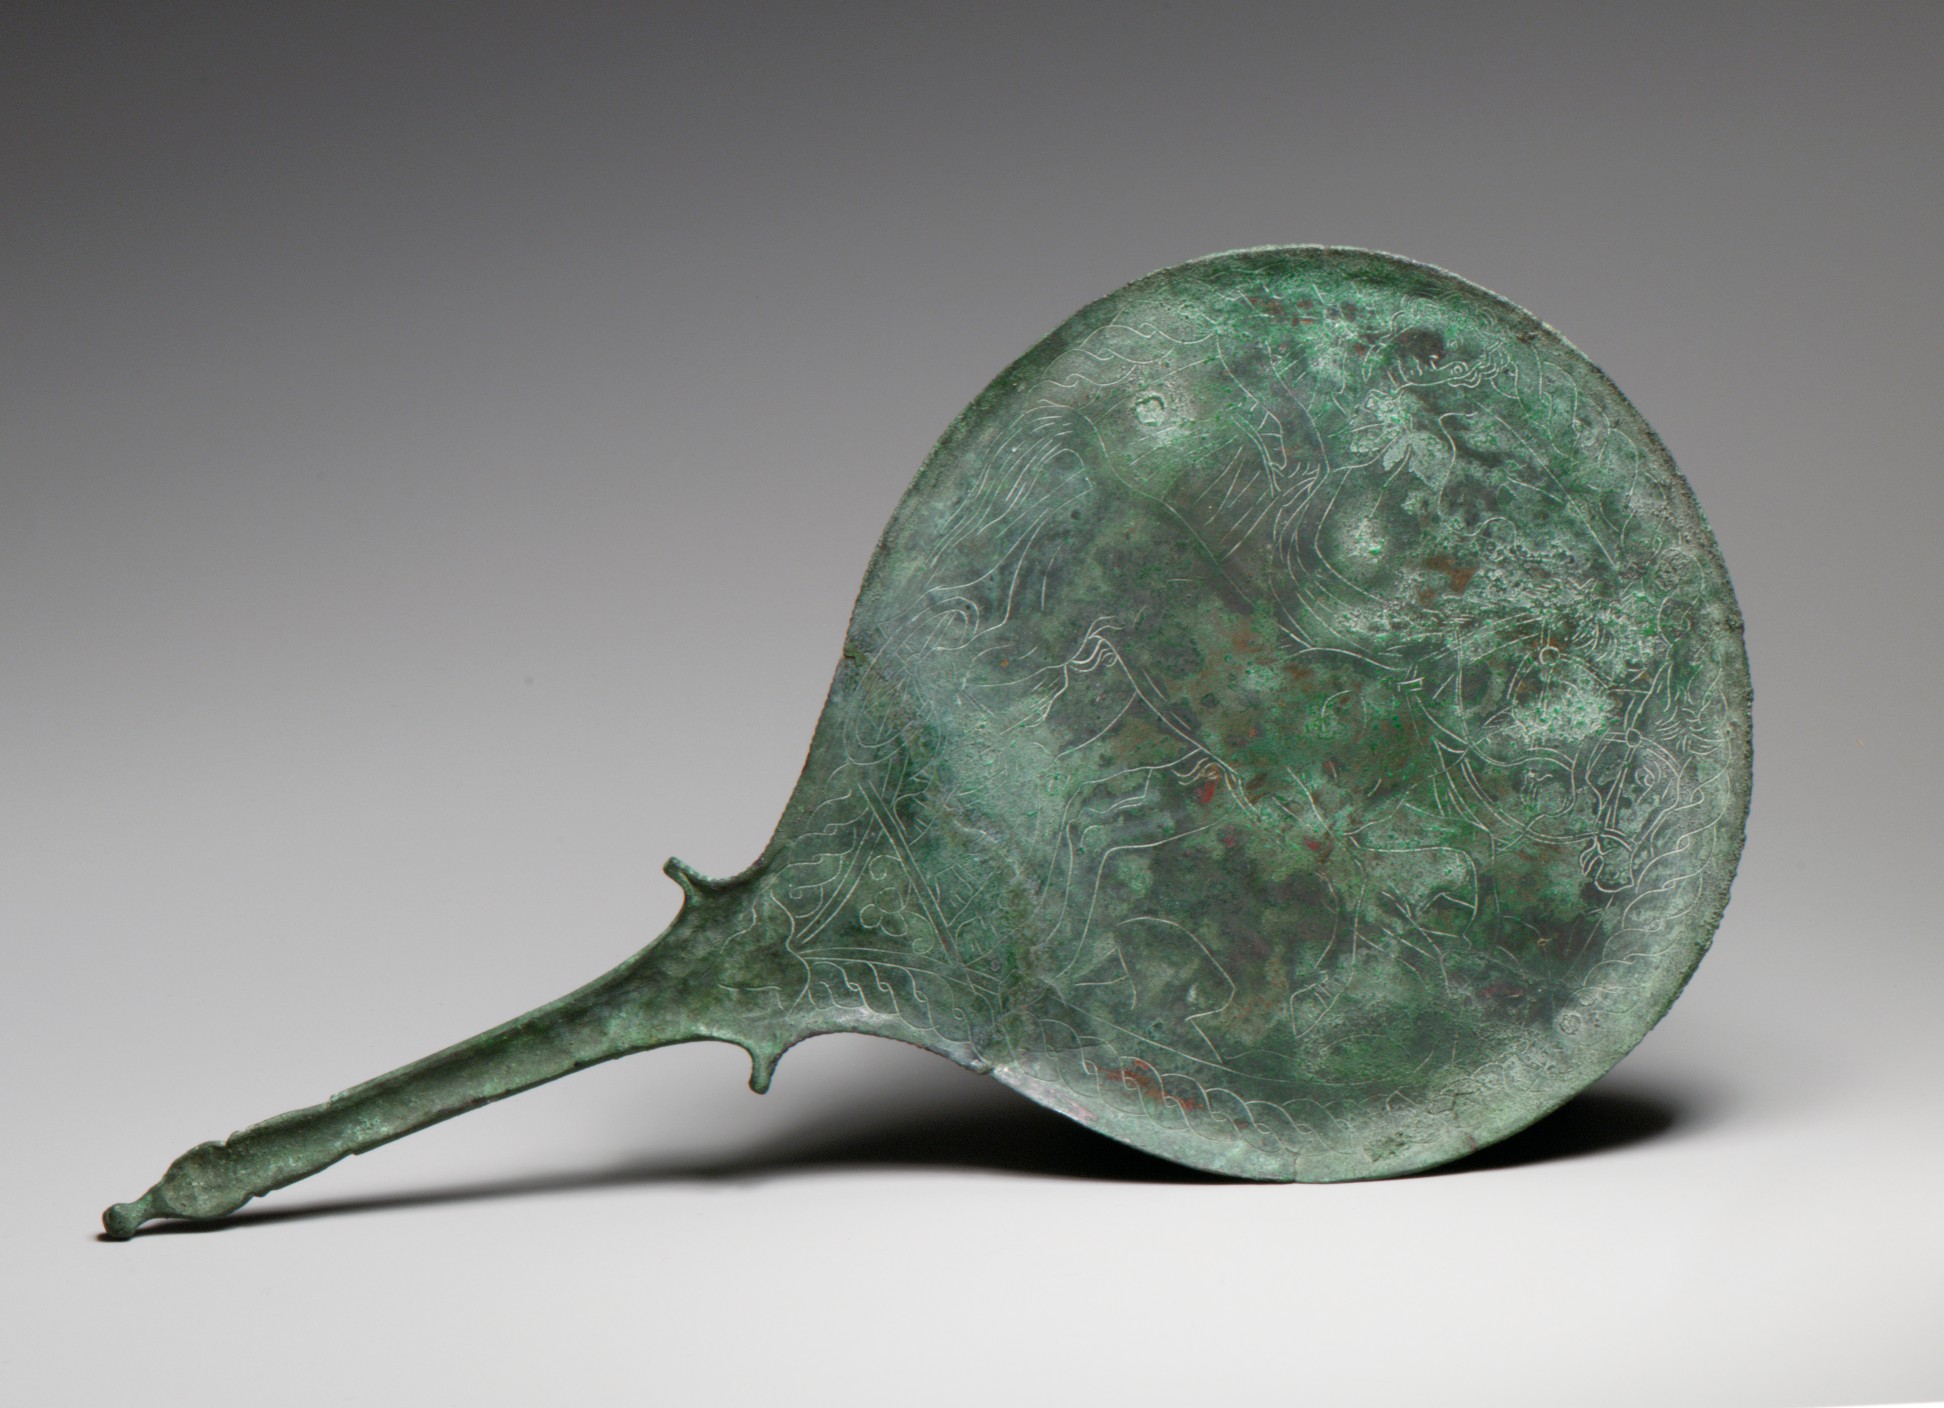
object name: mirror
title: Bronze mirror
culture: praenestine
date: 330-300 BCE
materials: bronze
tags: women,horses,chariots